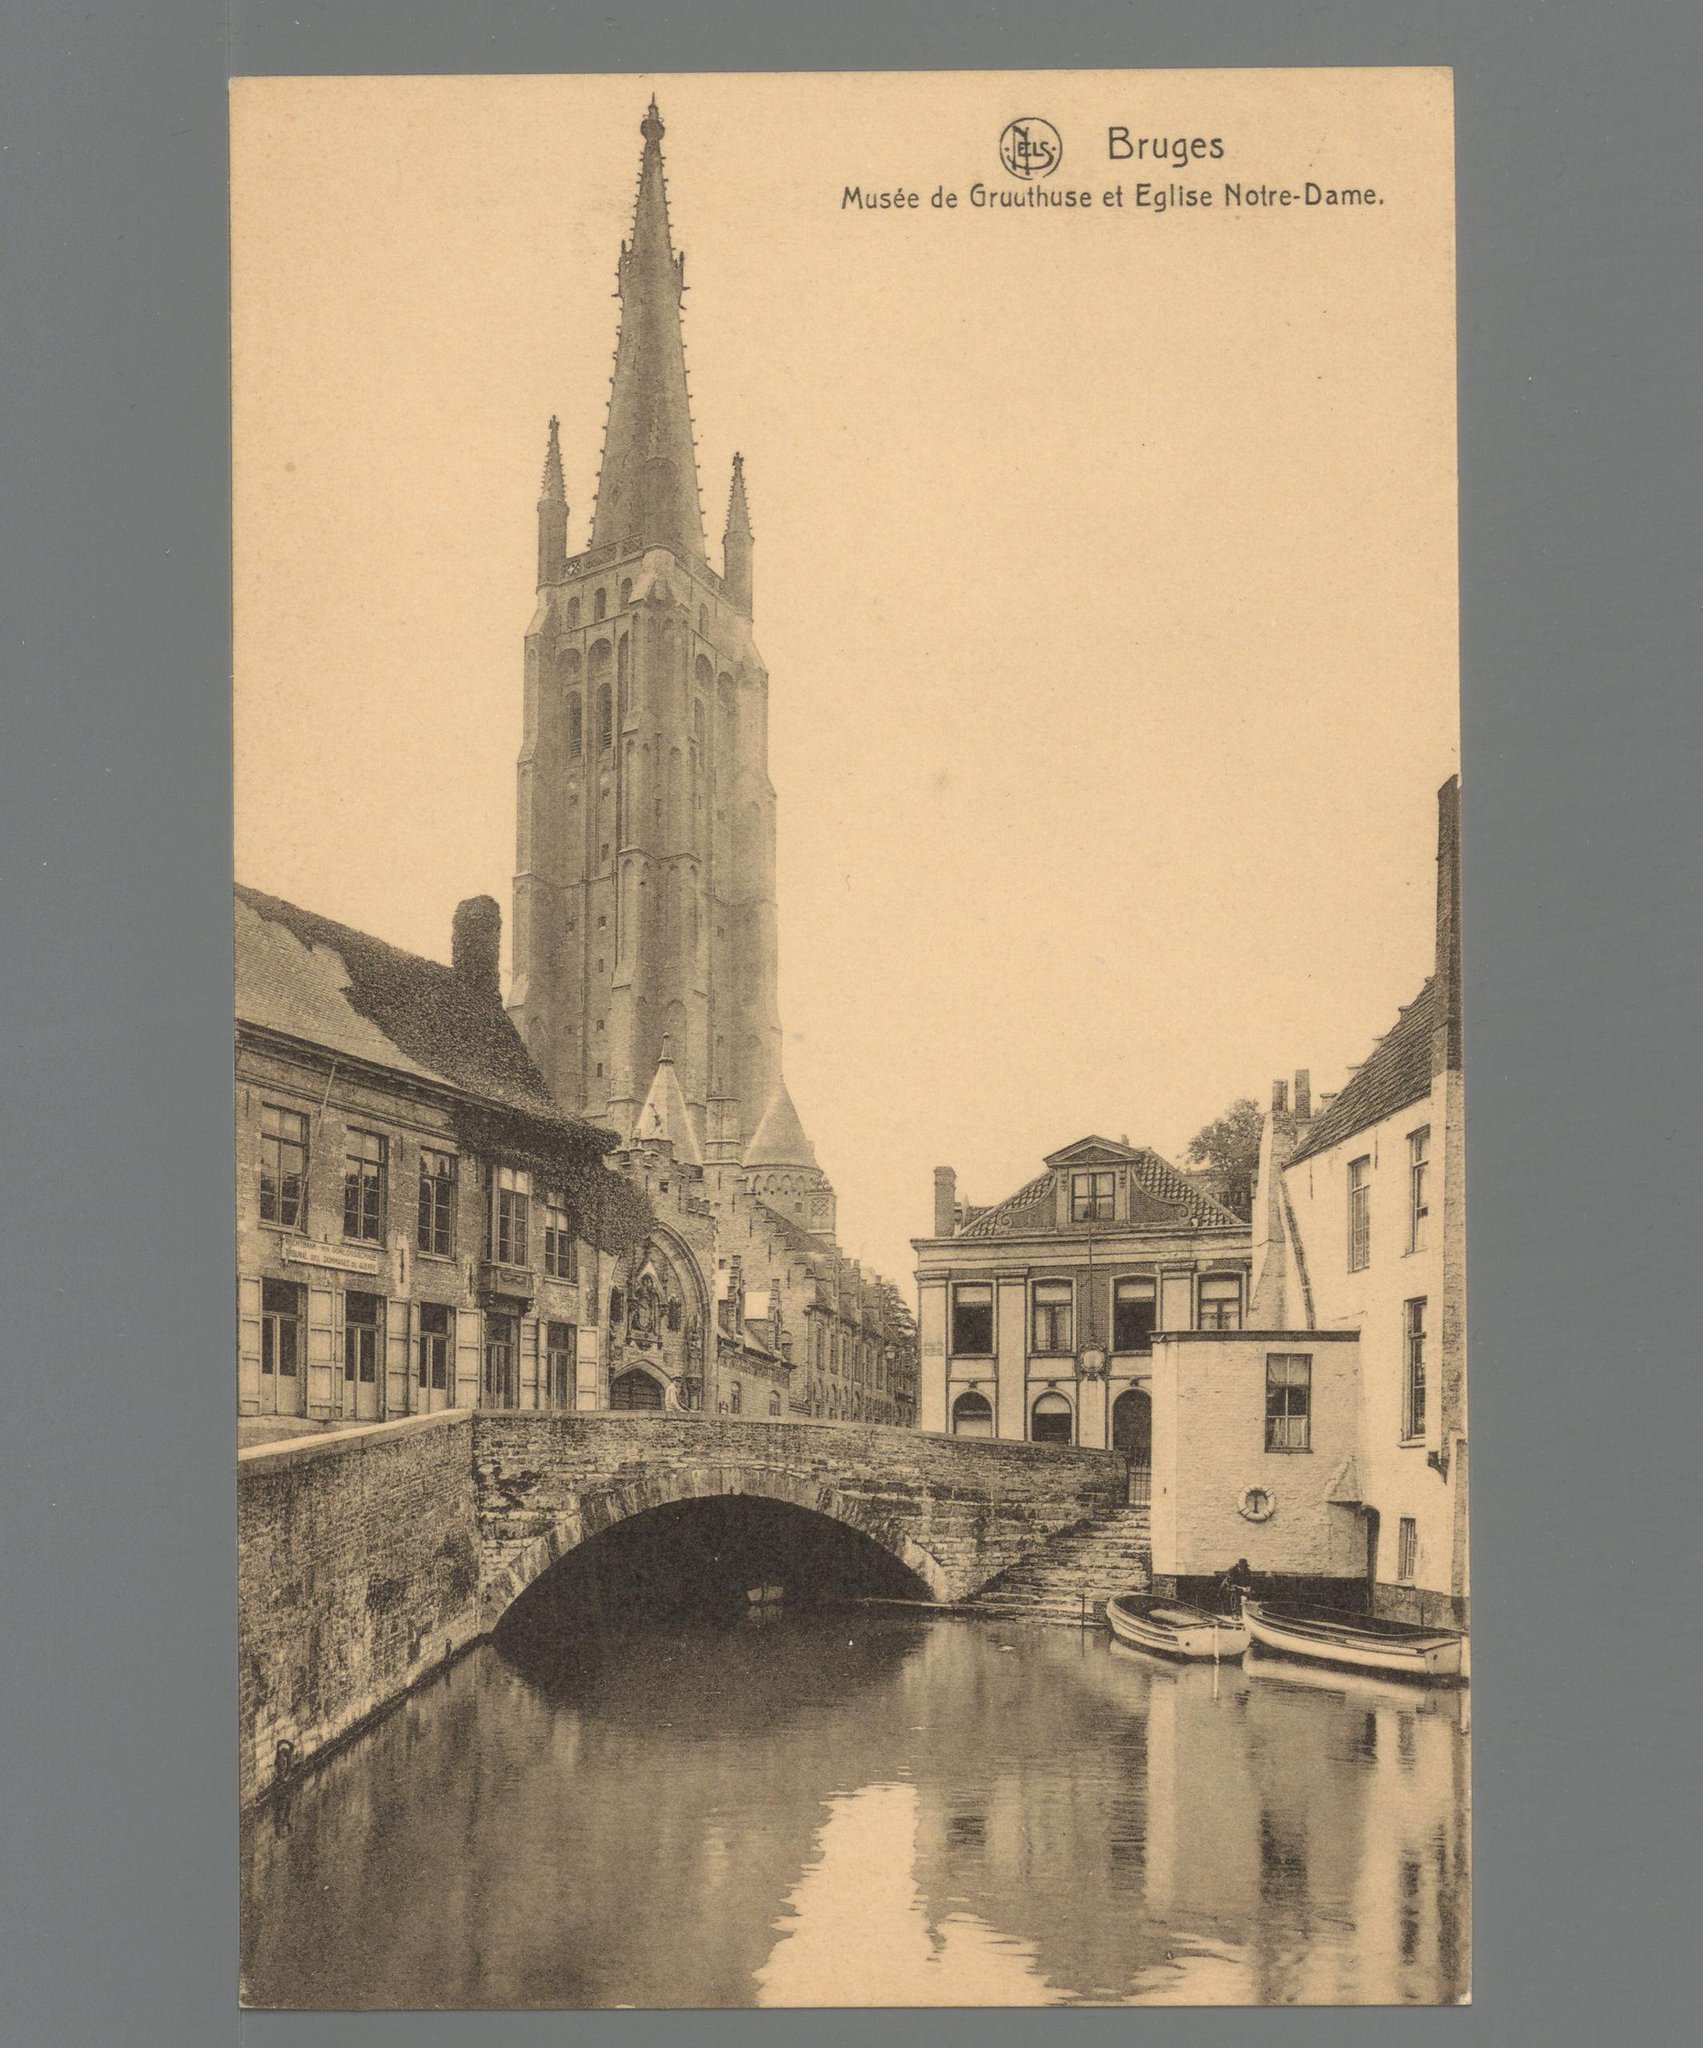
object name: photomechanical print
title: Série 12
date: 1913-1930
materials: cardboard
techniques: photograph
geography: brussels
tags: city-view, and landscape with man-made constructions, church (exterior), permanent exhibition, museum